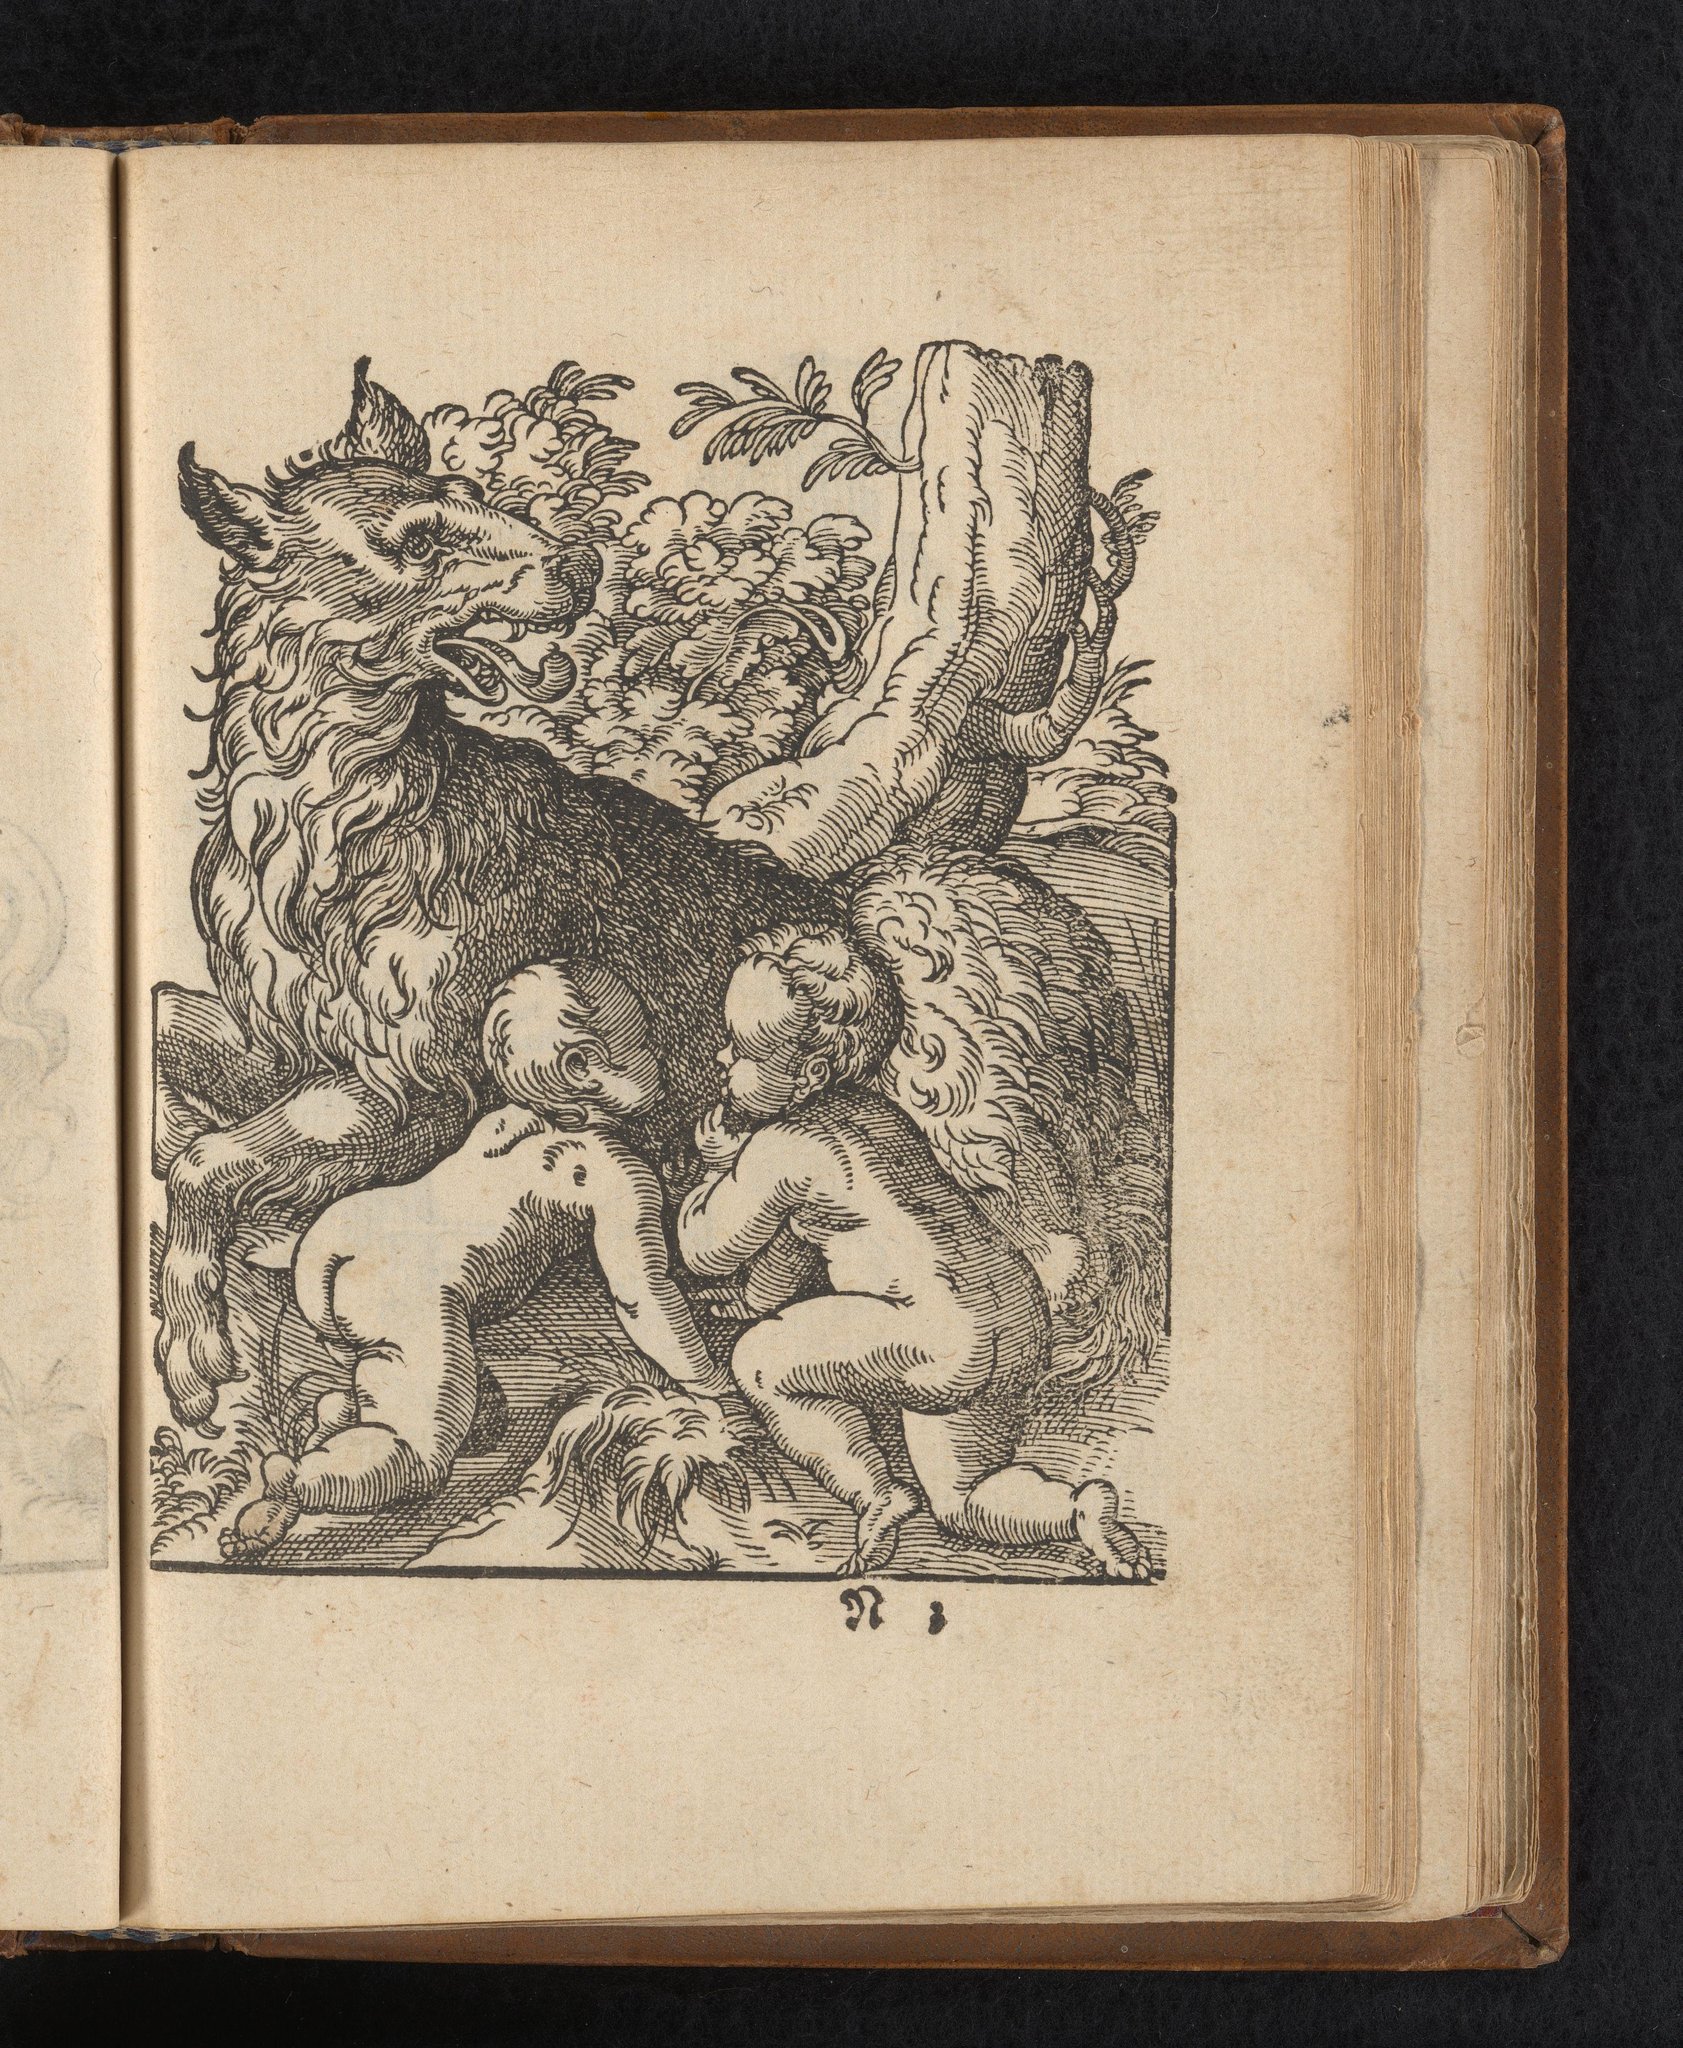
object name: print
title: Romulus en Remus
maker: Anonymous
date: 1578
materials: paper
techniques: woodcut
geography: nuremberg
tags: romulus and remus are washed ashore and suckled by a she-wolf; 'lupa romana'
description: Romulus en Remus zogen bij de wolvin. Onderdeel van het modelboek Enchiridion artis pingendi, fingendi & sculpendi met 108 figuren bedoeld voor beginnende schilders, beeldhouwers en prentmakers.